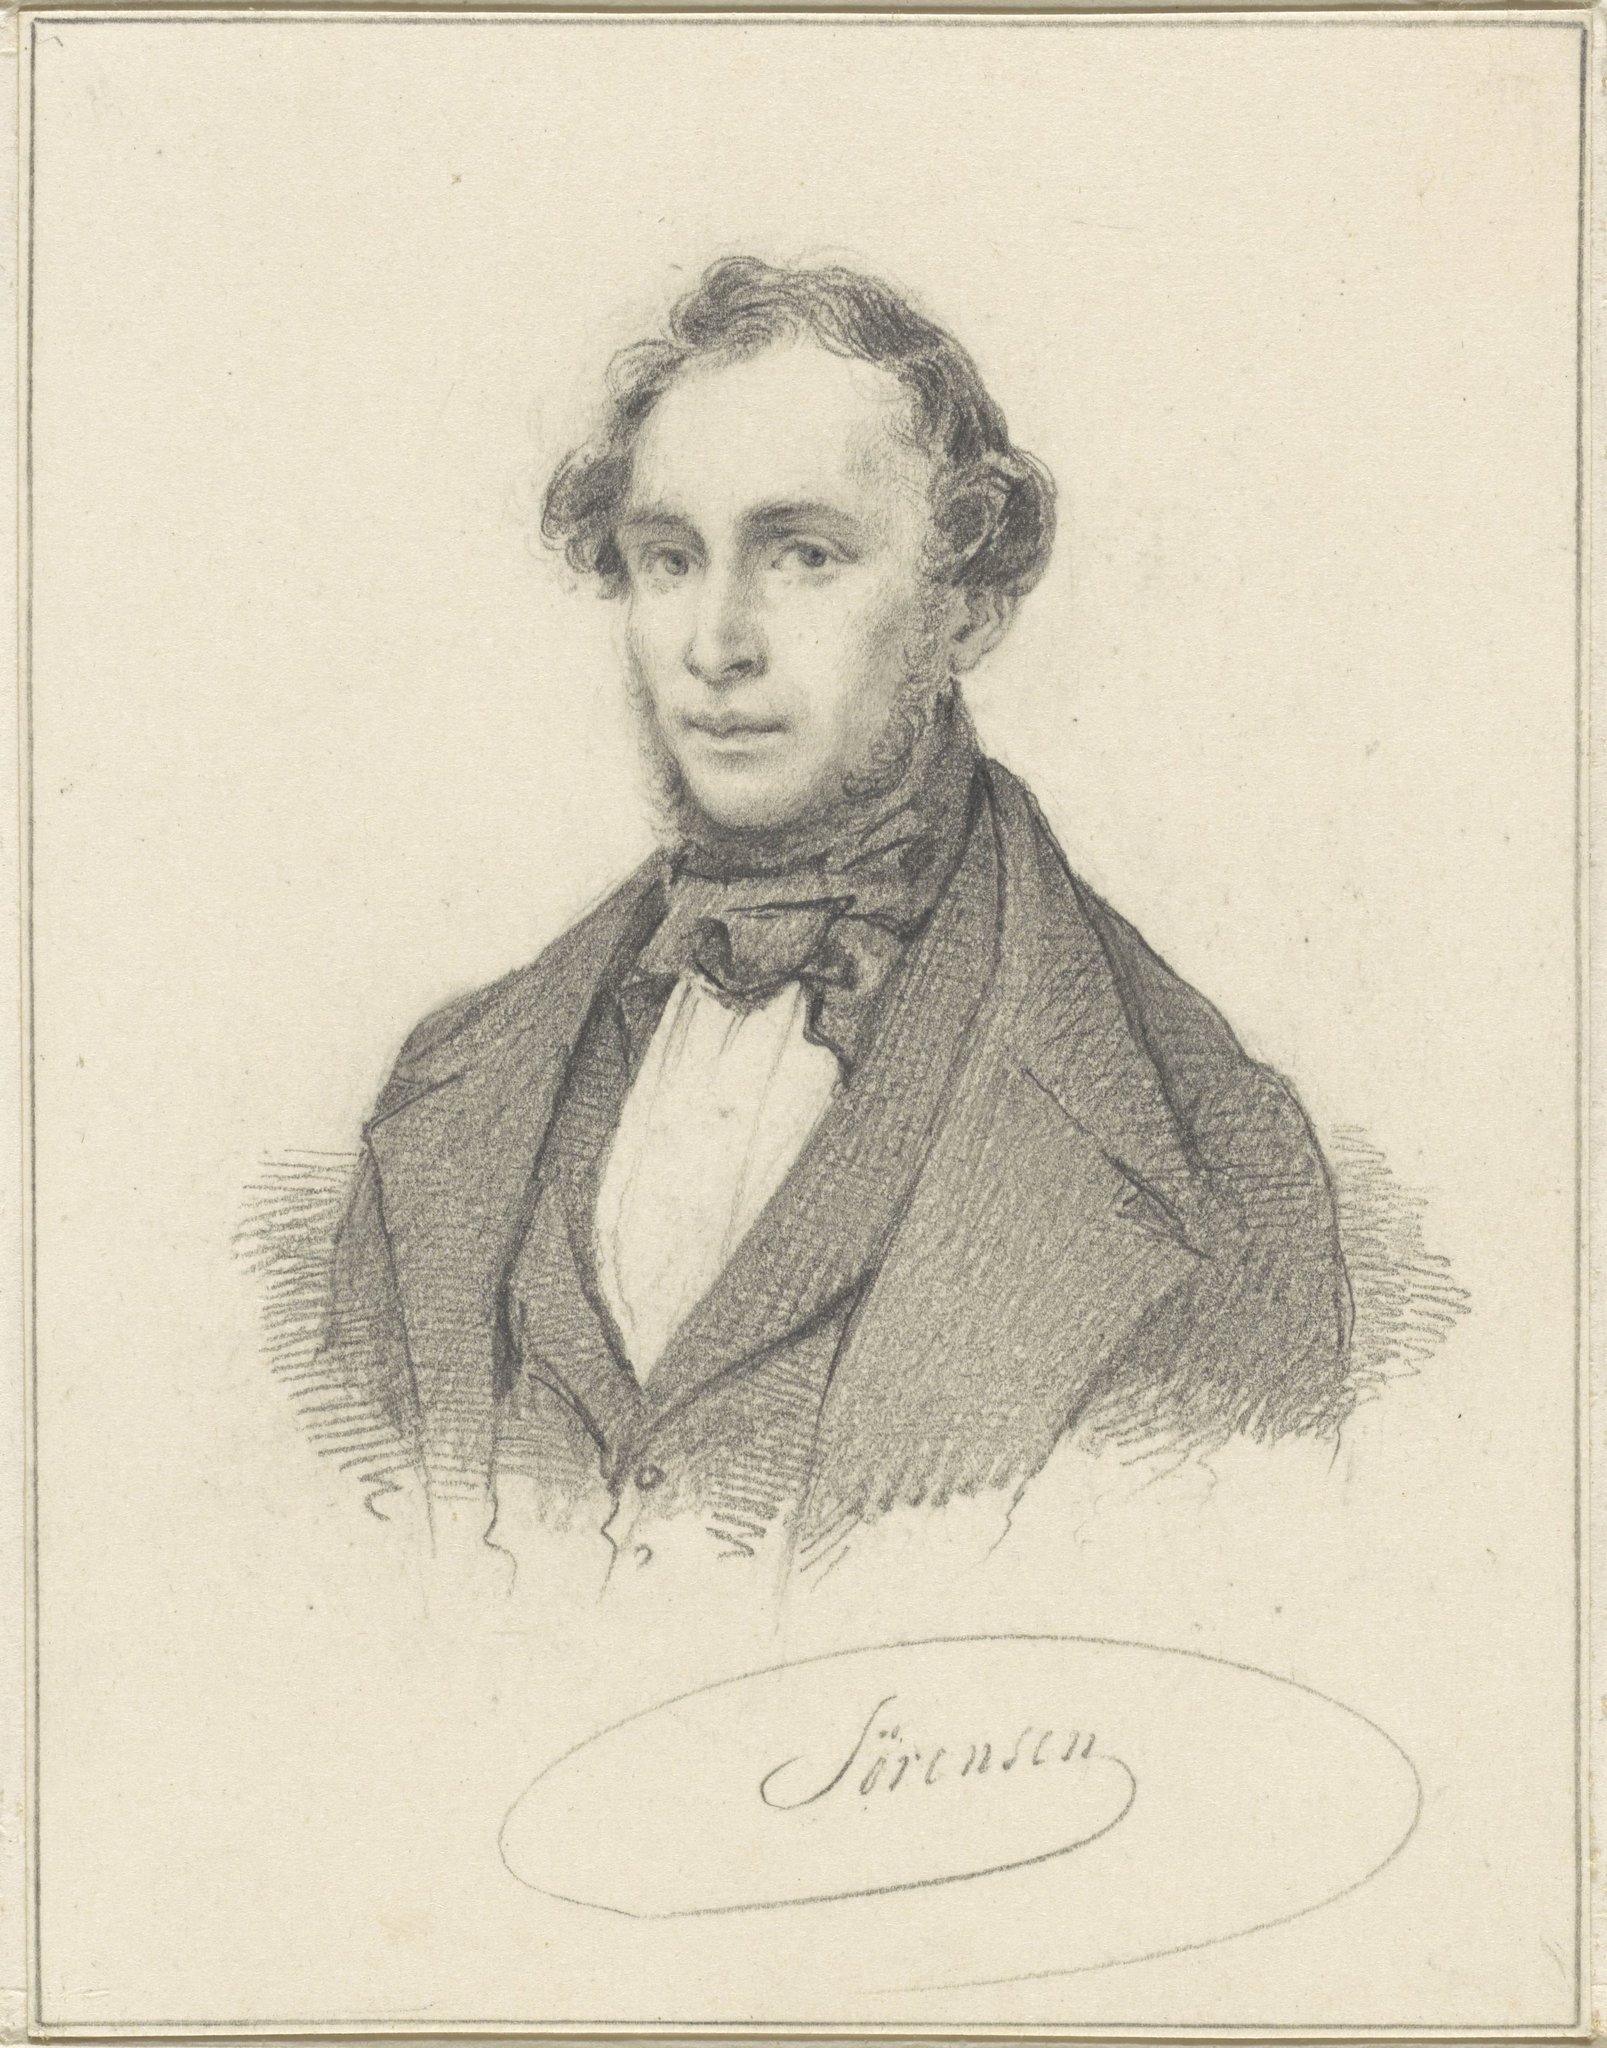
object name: drawing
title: Zelfportret van Jacobus Sörensen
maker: jacobus sörensen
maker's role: painter, print maker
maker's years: 1812-1857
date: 1822-1857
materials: paper, pencil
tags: amsterdam, painter, print maker, jacobus sörensen, historical persons, portrait, self-portrait of artist